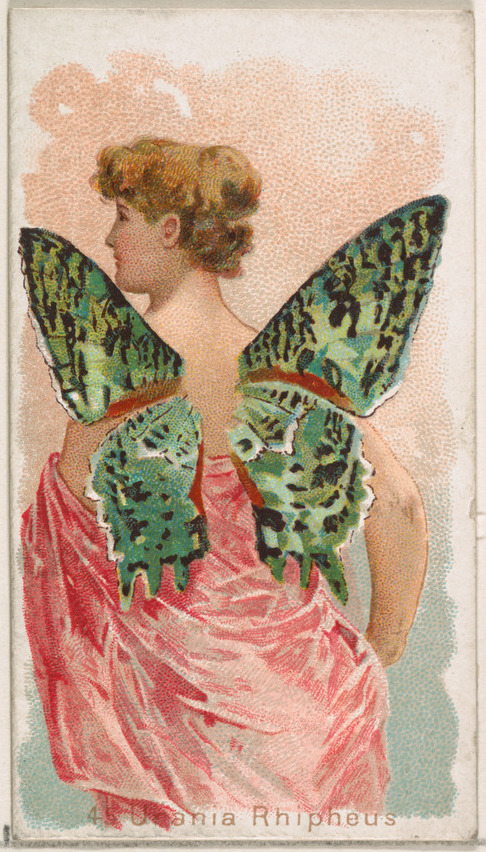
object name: print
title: Card 45, Urania Rhipheus, from the Butterflies series (N183) issued by Wm. S. Kimball & Co.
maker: william s. kimball & company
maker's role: publisher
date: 1888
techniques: color lithograph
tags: women,butterflies